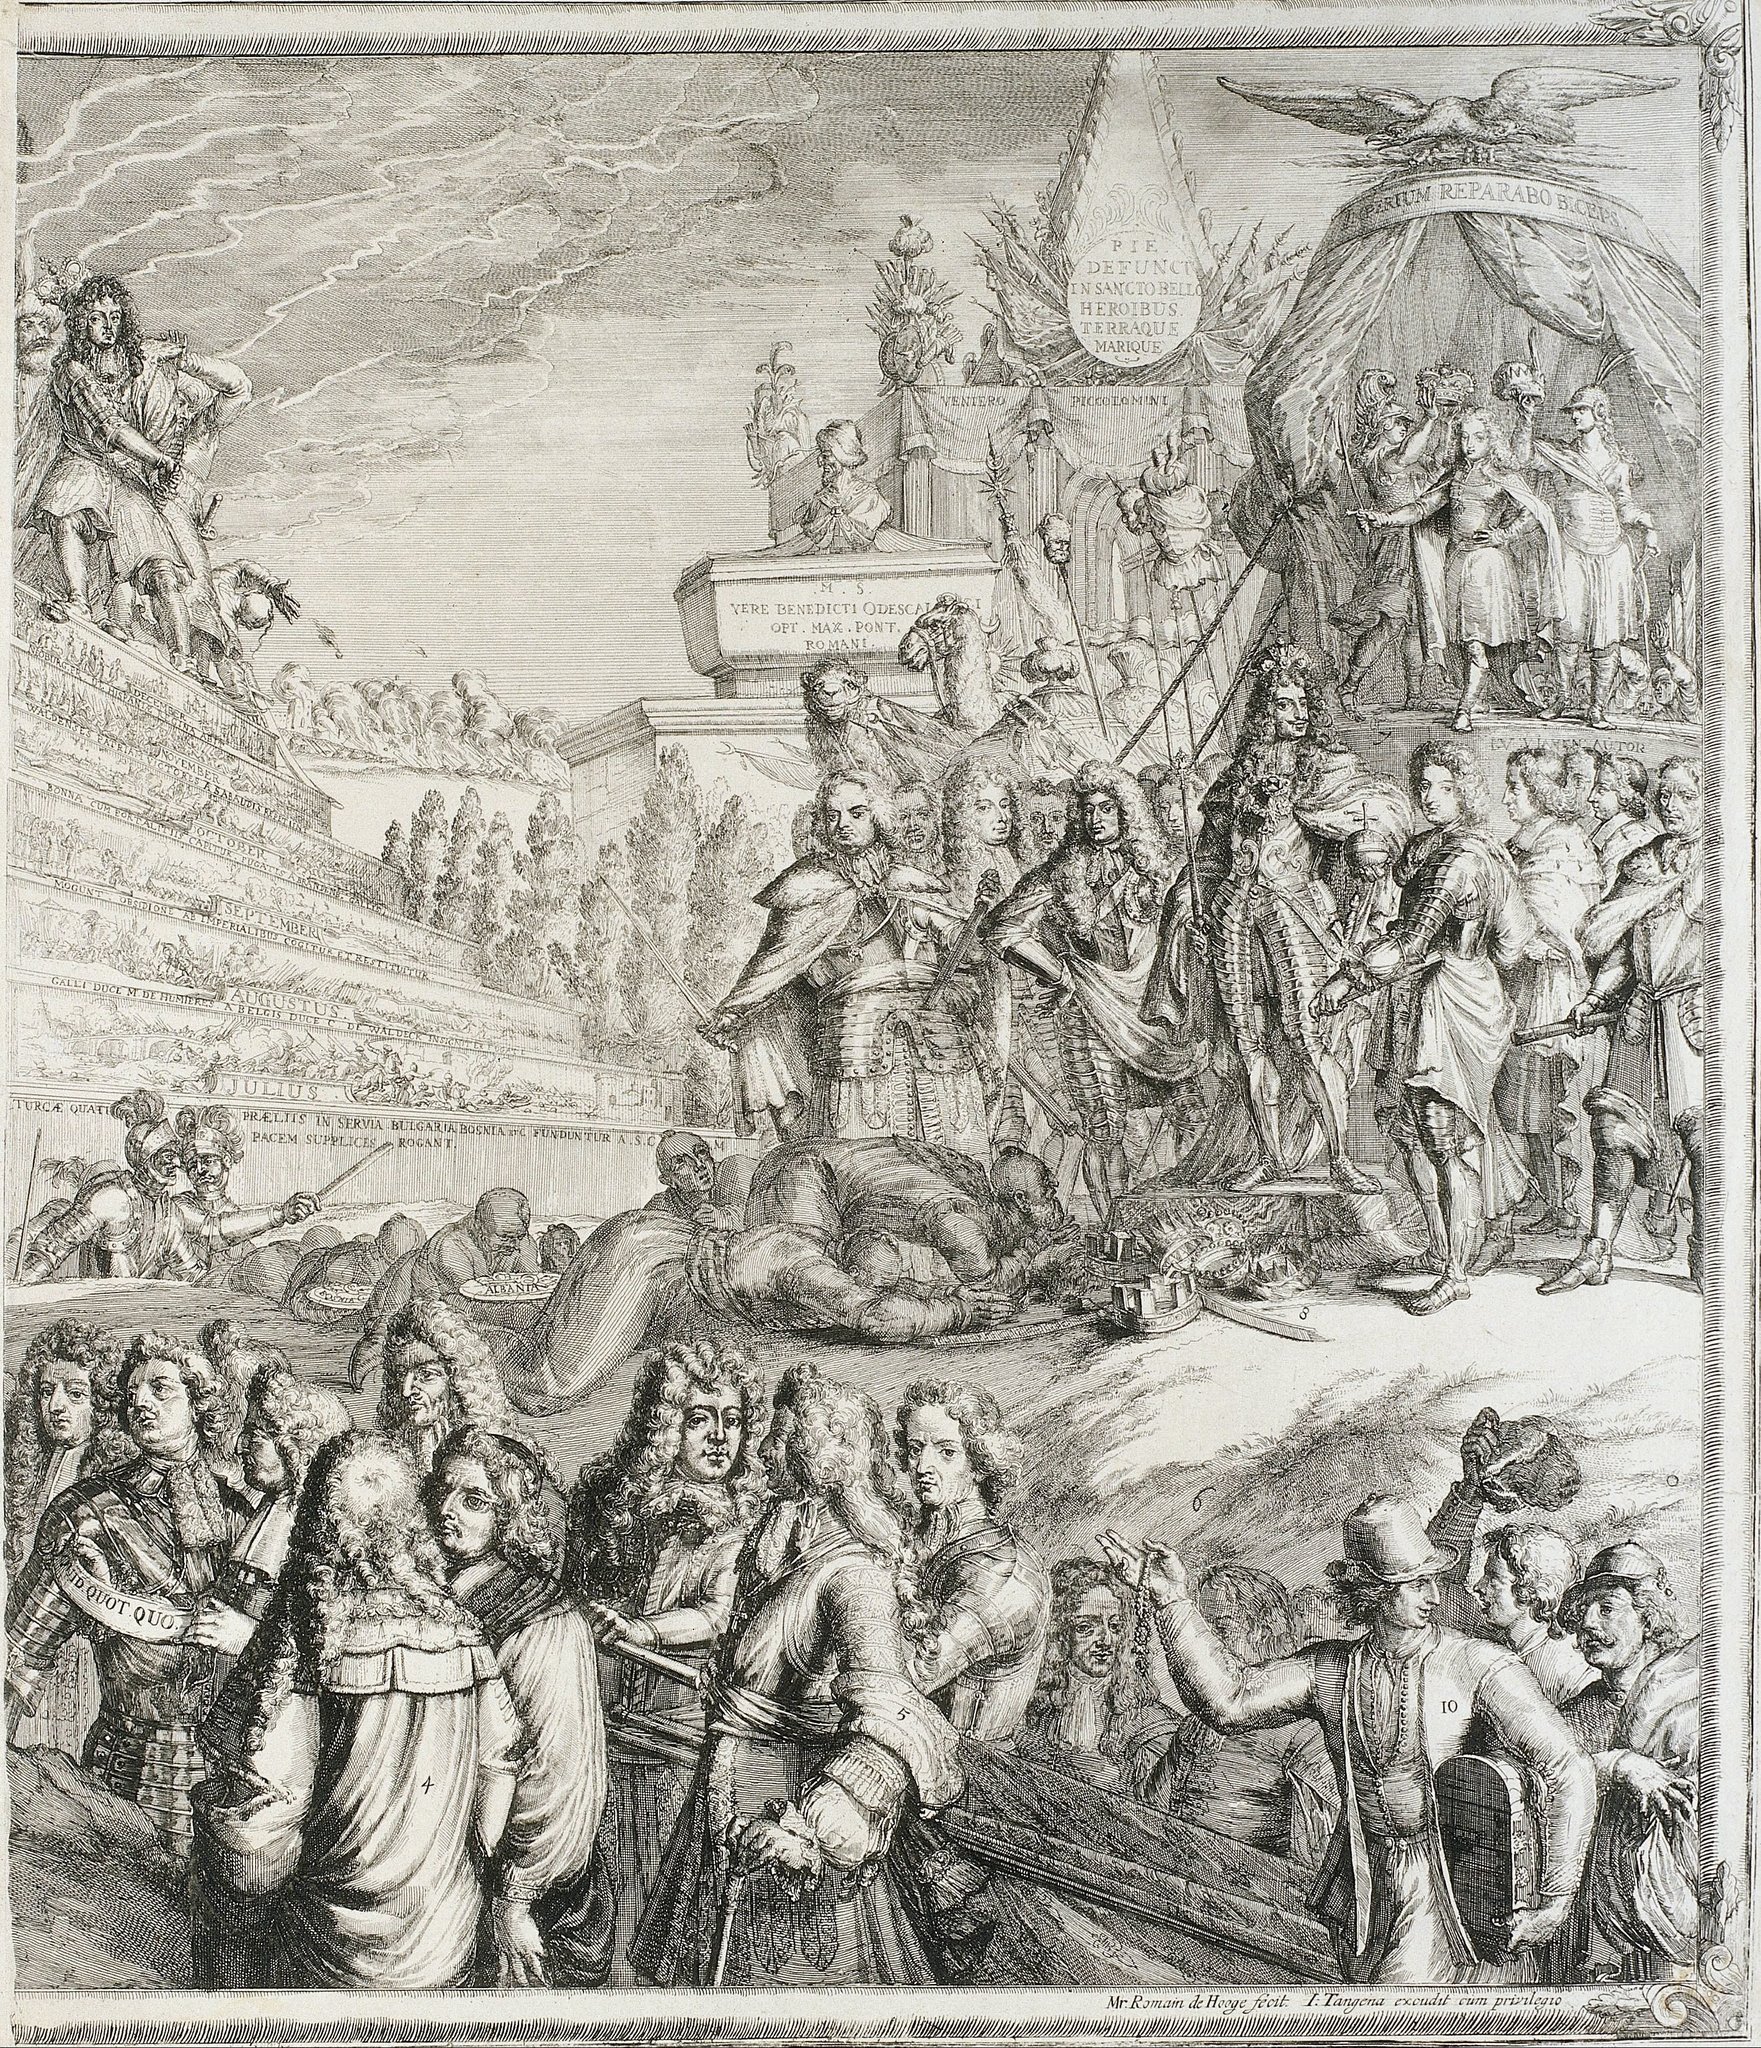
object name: print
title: Allegorie op de gebeurtenissen in 1689 met Willem III en Maria op de troon (rechter helft)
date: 1690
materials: paper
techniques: etching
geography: netherlands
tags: the hague, william iii (prince of orange and king of england, scotland, and ireland), london, maria ii stuart (koningin van engeland, schotland en ierland), vienna, leopold i (keizer van duitsland), jozef i (duits keizer)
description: Allegorie op de gebeurtenissen in 1689 met de stadhouder-koning Willem III en koningin Maria op de troon. Rechter helft van twee bladen die samen één voorstelling vormen. Op de voorgrond legeraanvoerders en rechts Hollandse matrozen. Hierachter knielen overwonnen Turken voor keizer Leopold I, staande tussen vorsten. Hierboven de kroning van Jozef I tot koning van Hongarije en Rooms koning (24 januari 1690). Links de helft van een piramide met de gebeurtenissen van de tweede zes maanden. Bovenaan trekt prins van Oranje zijn zwaard. Sommige elementen in de voorstelling aangeduid met cijfers.